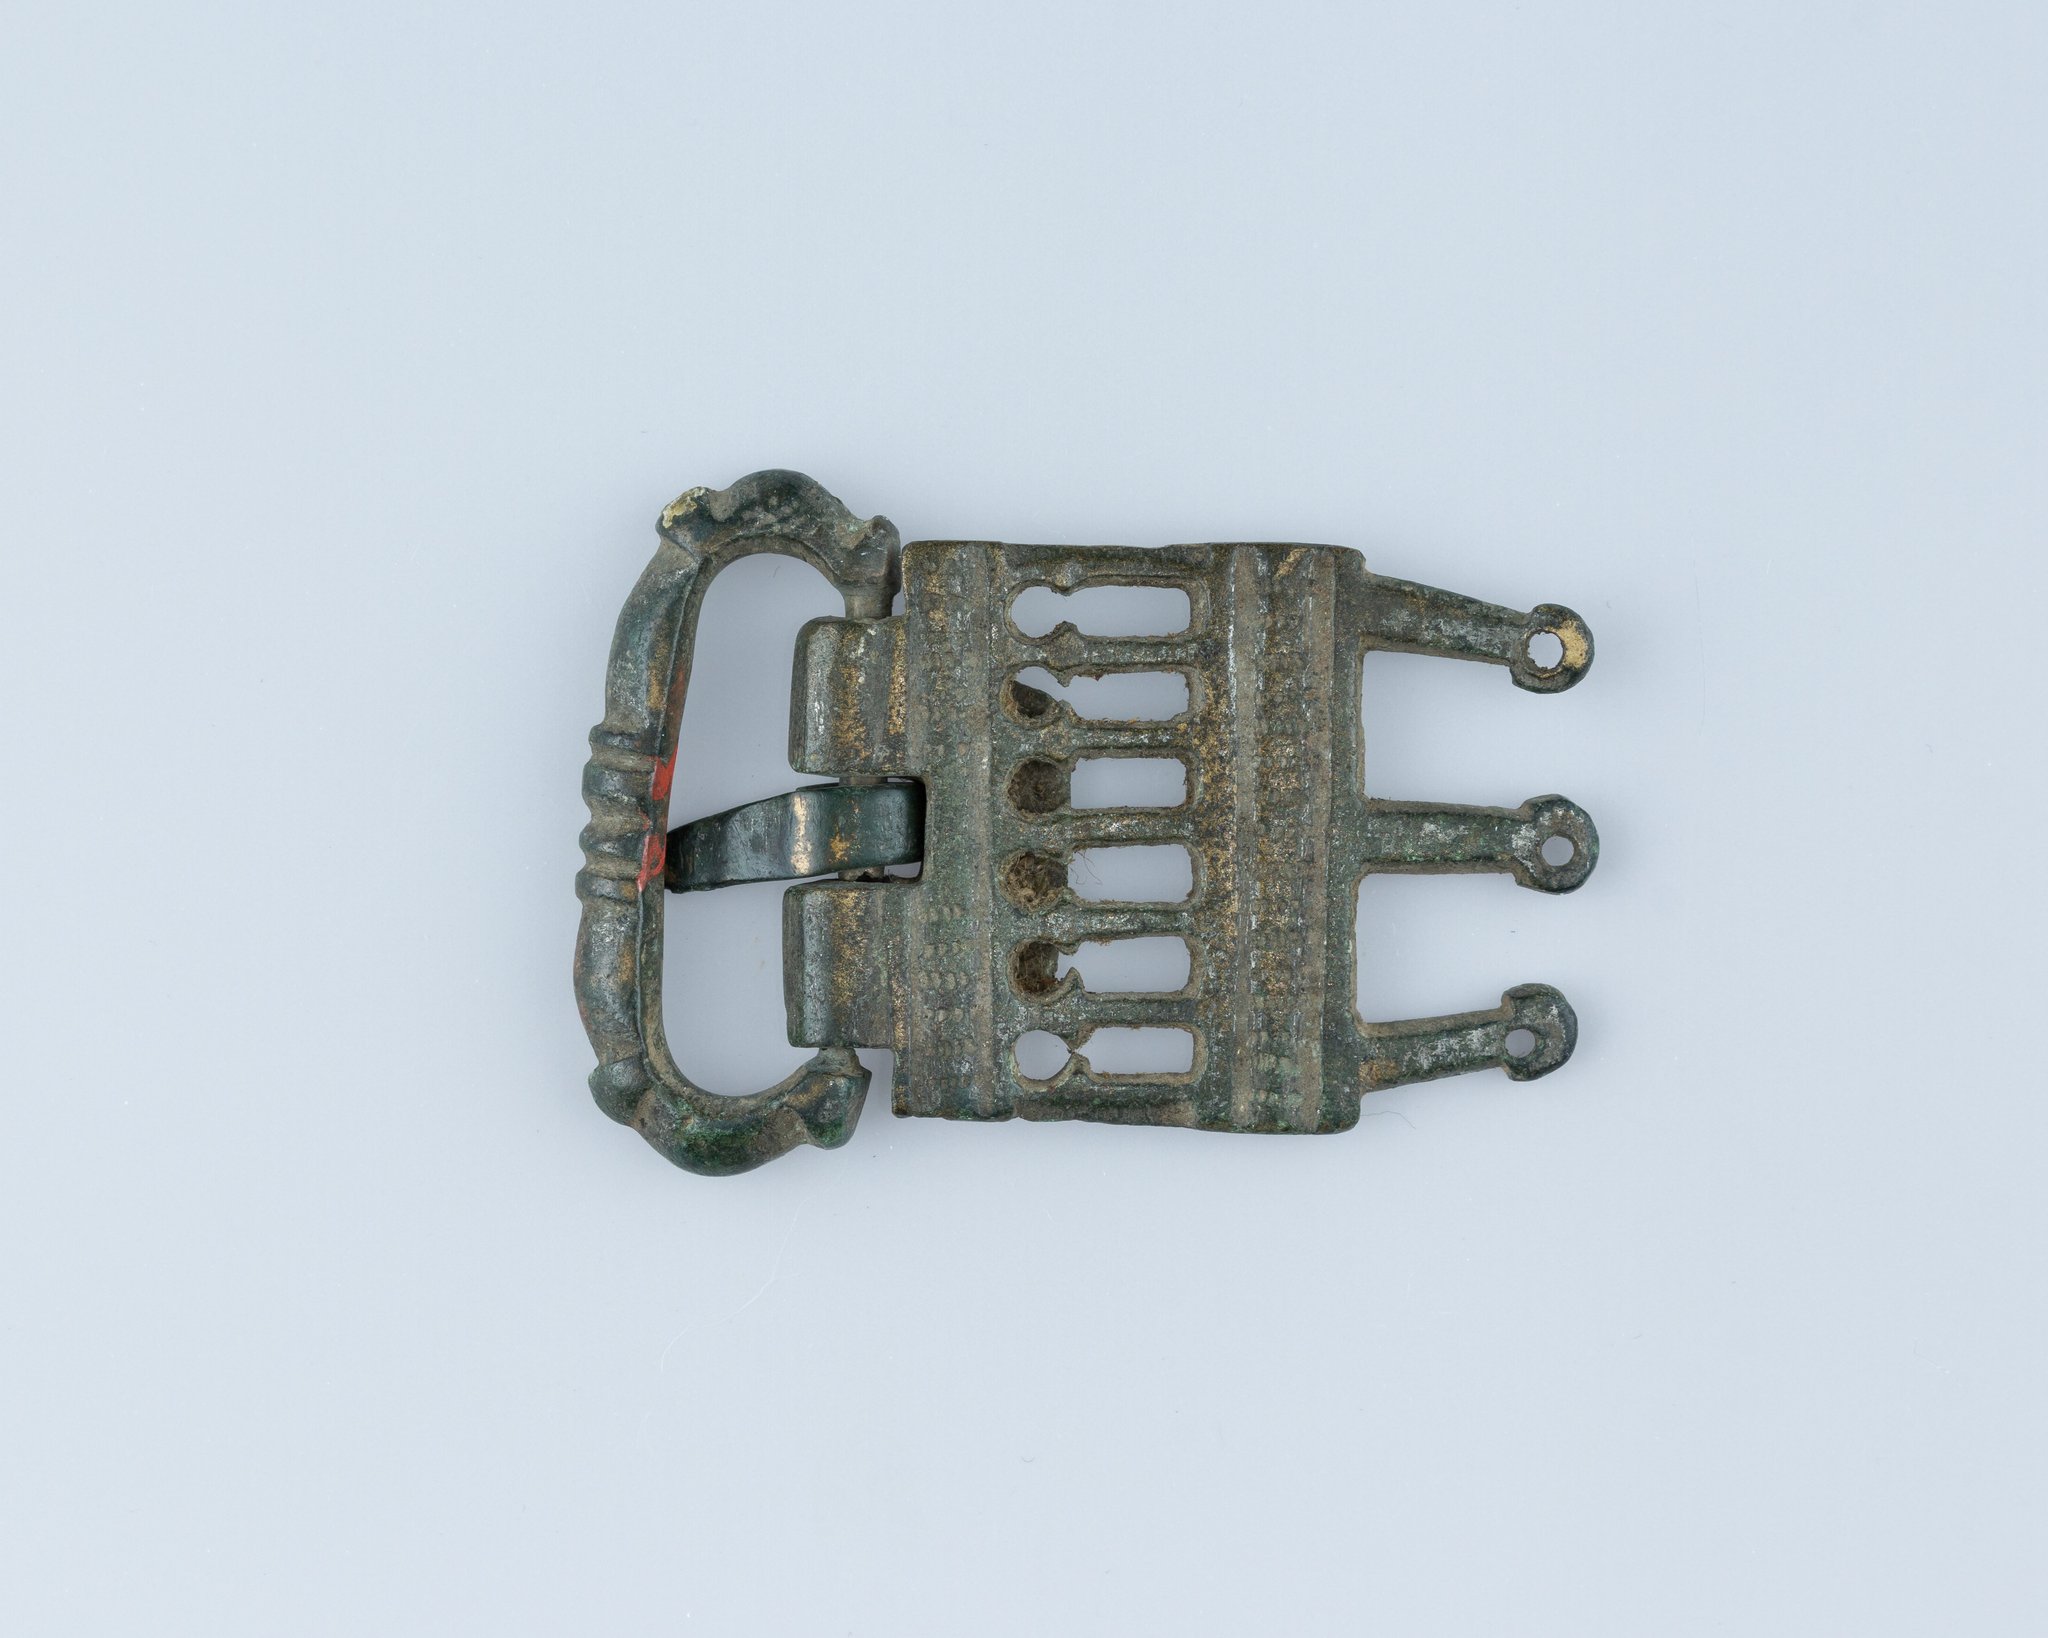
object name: buckle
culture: roman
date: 50 BCE-500 CE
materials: bronze